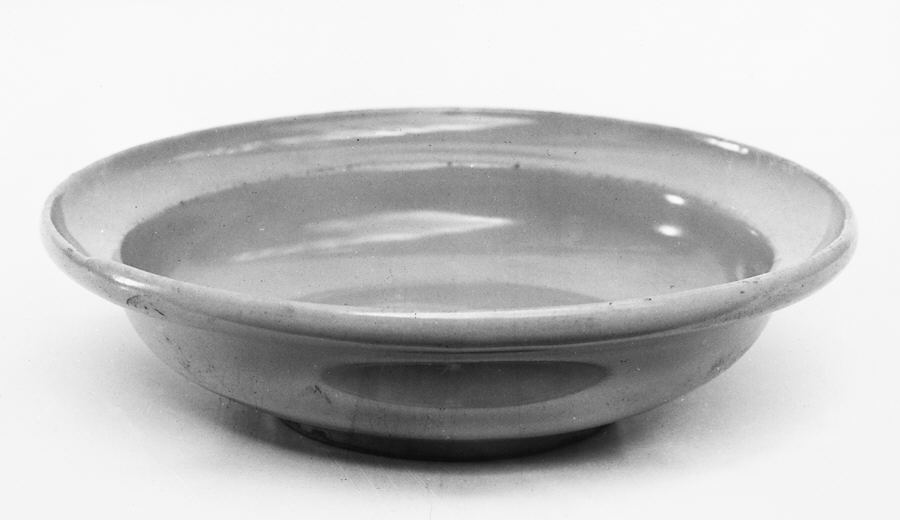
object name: dish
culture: chinese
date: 1101-1300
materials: ceramic glaze, glaze, porcelain